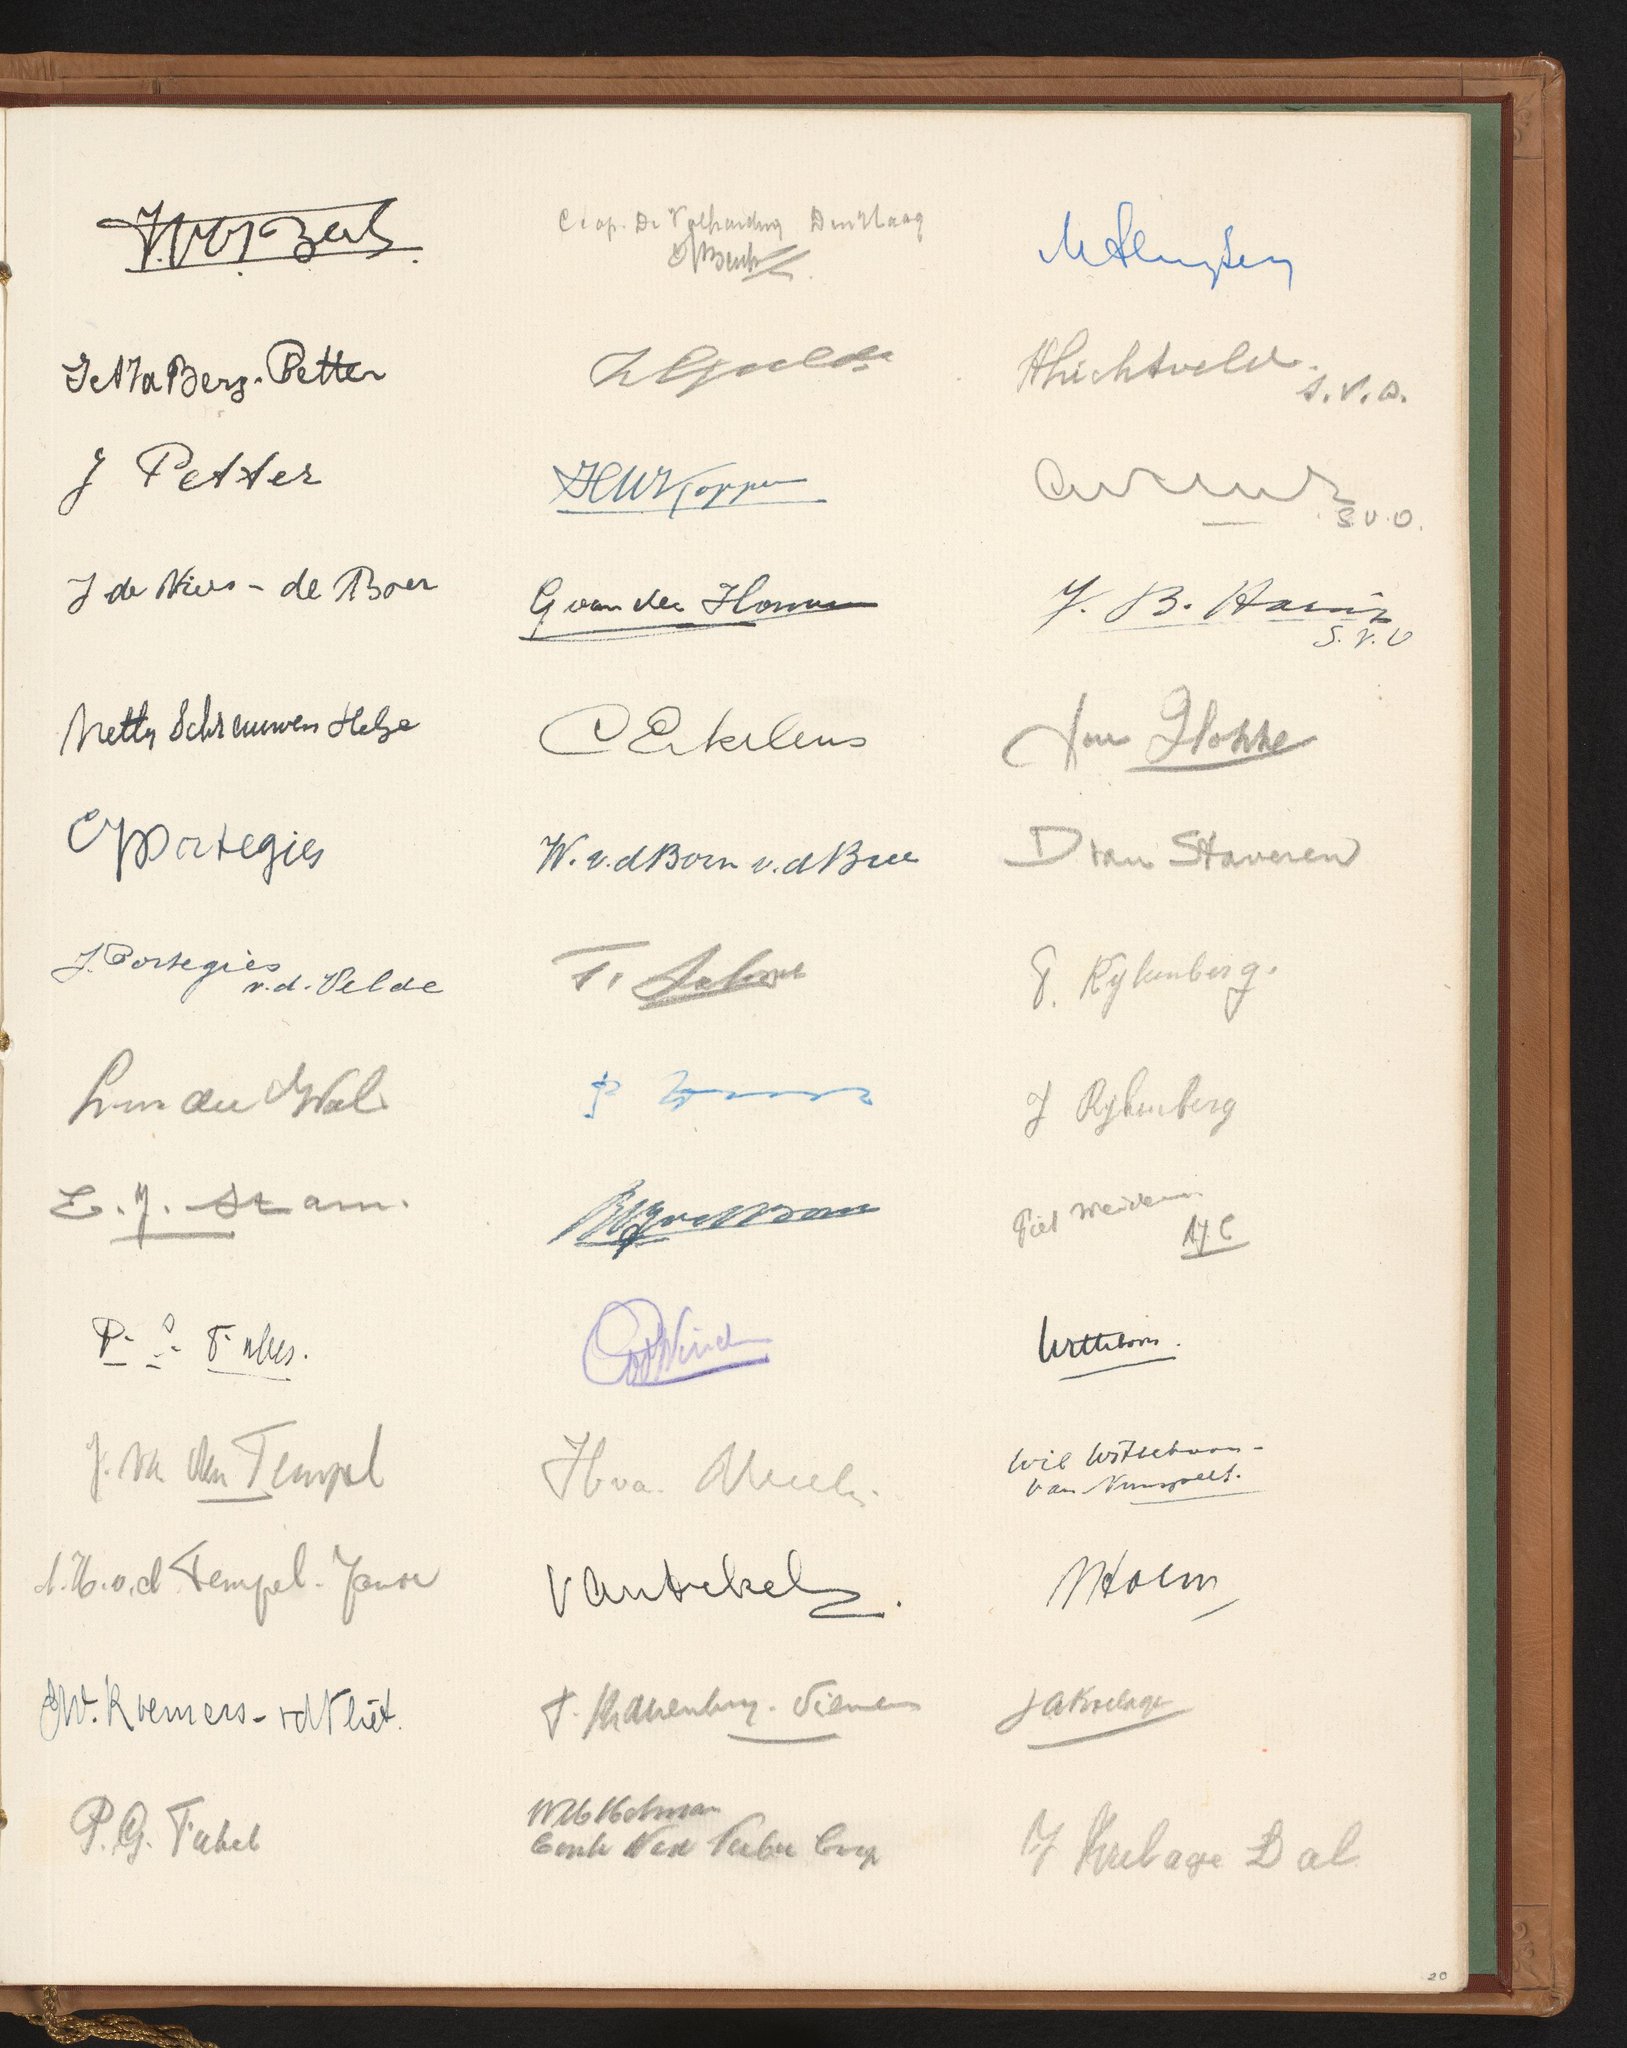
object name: album leaf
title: Blad met handtekeningen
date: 1949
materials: ink, paper, pencil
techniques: handwriting, pen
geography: netherlands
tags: modern professional organization, trade union, reception, cocktail party, handwriting, written text, amsterdam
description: Blad met handtekeningen van aanwezigen op het afscheidsfeest. Onderdeel van het fotoalbum ter gelegenheid van het afscheid van Evert Kupers als voorzitter van de NVV op 14 juli 1949 in Amsterdam.